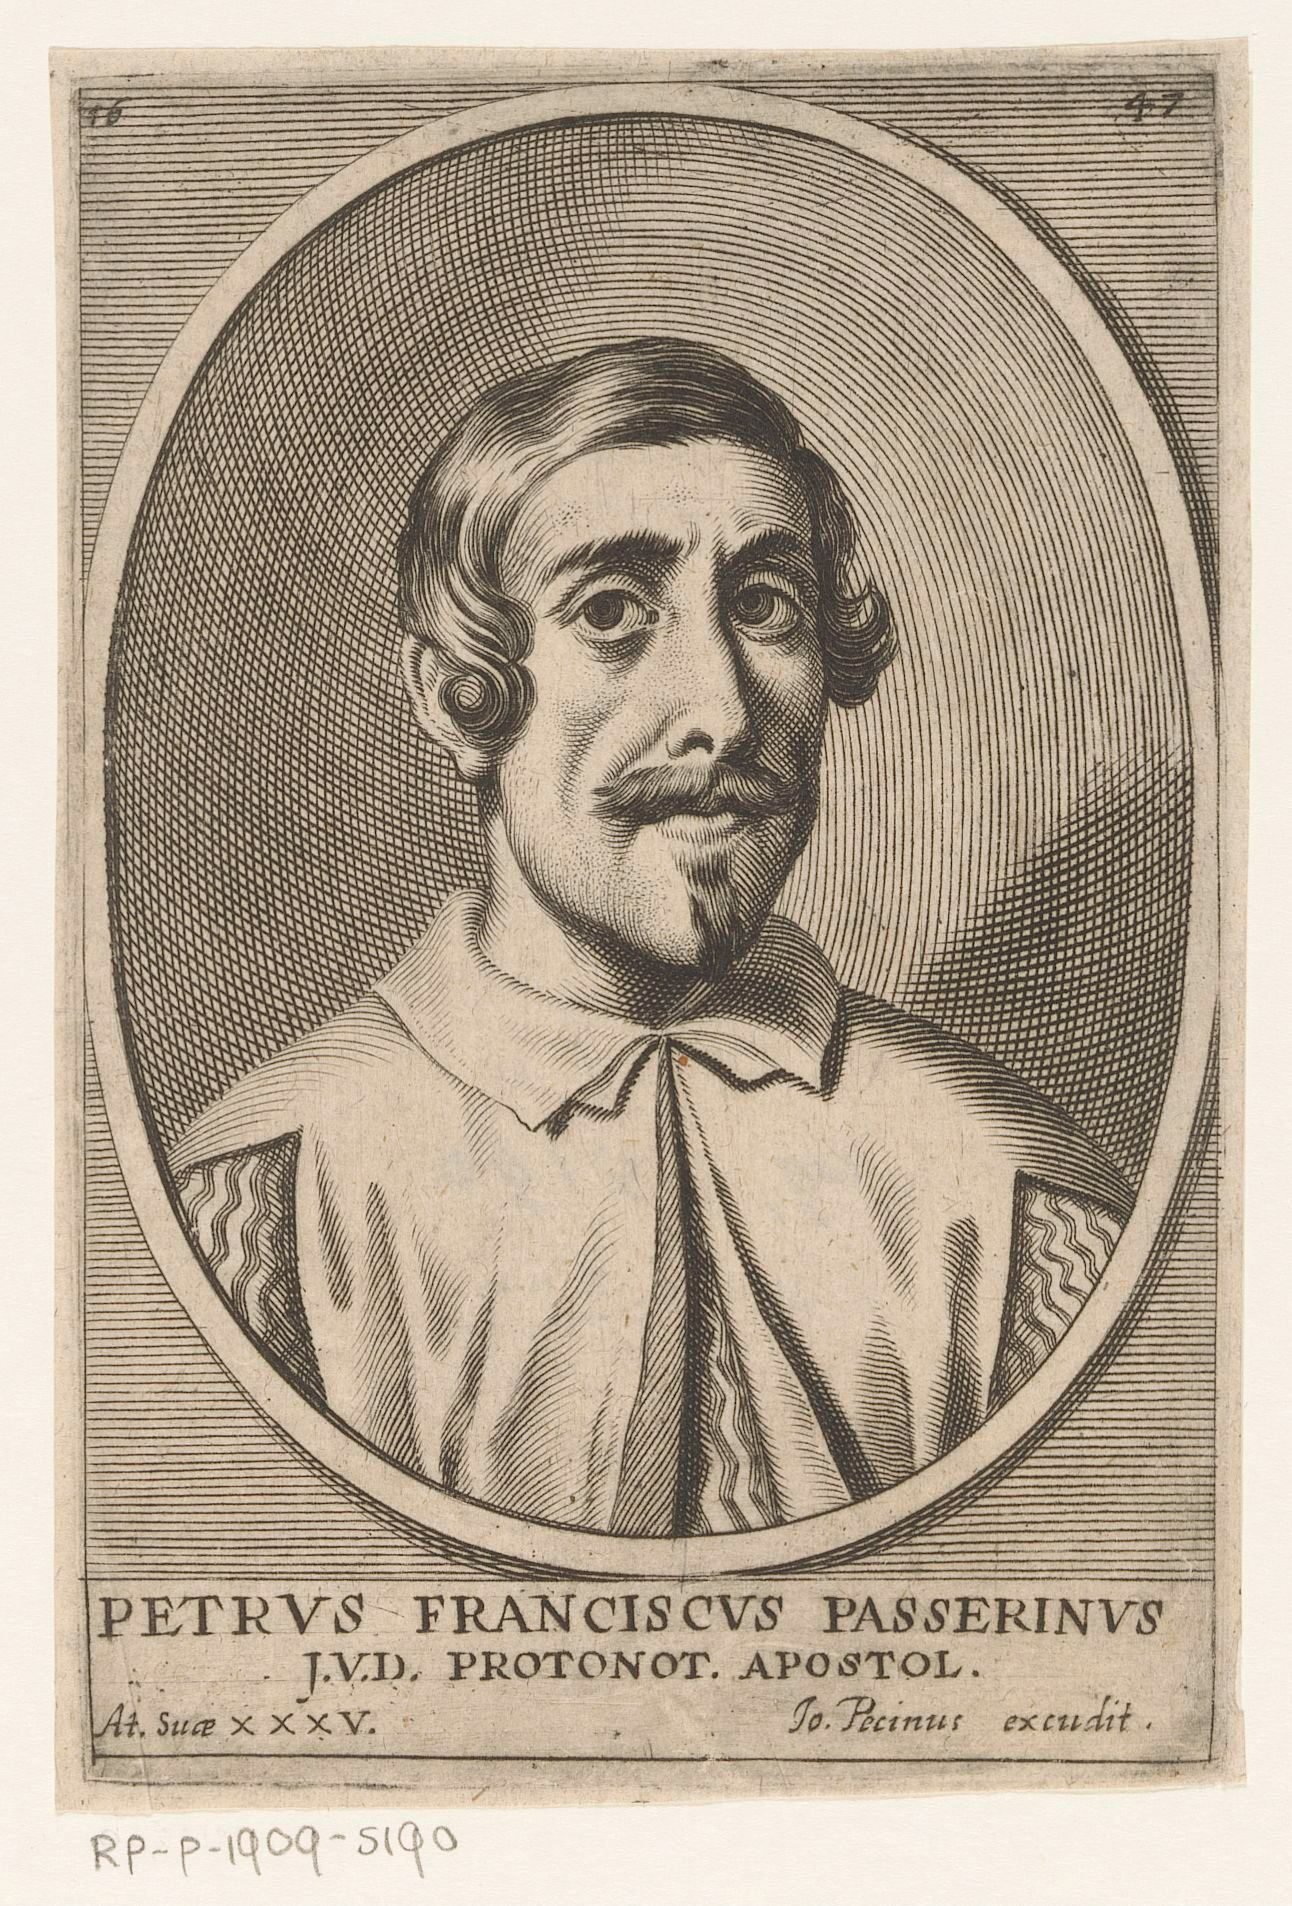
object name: print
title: Portret van geestelijke Pier Francesco Passerini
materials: paper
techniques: engraving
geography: venice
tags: clergyman, historical persons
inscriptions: collector's mark: Lugt 2228, number: ‘68’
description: Genummerd linksboven: 16. Genummerd rechtsboven: 47.